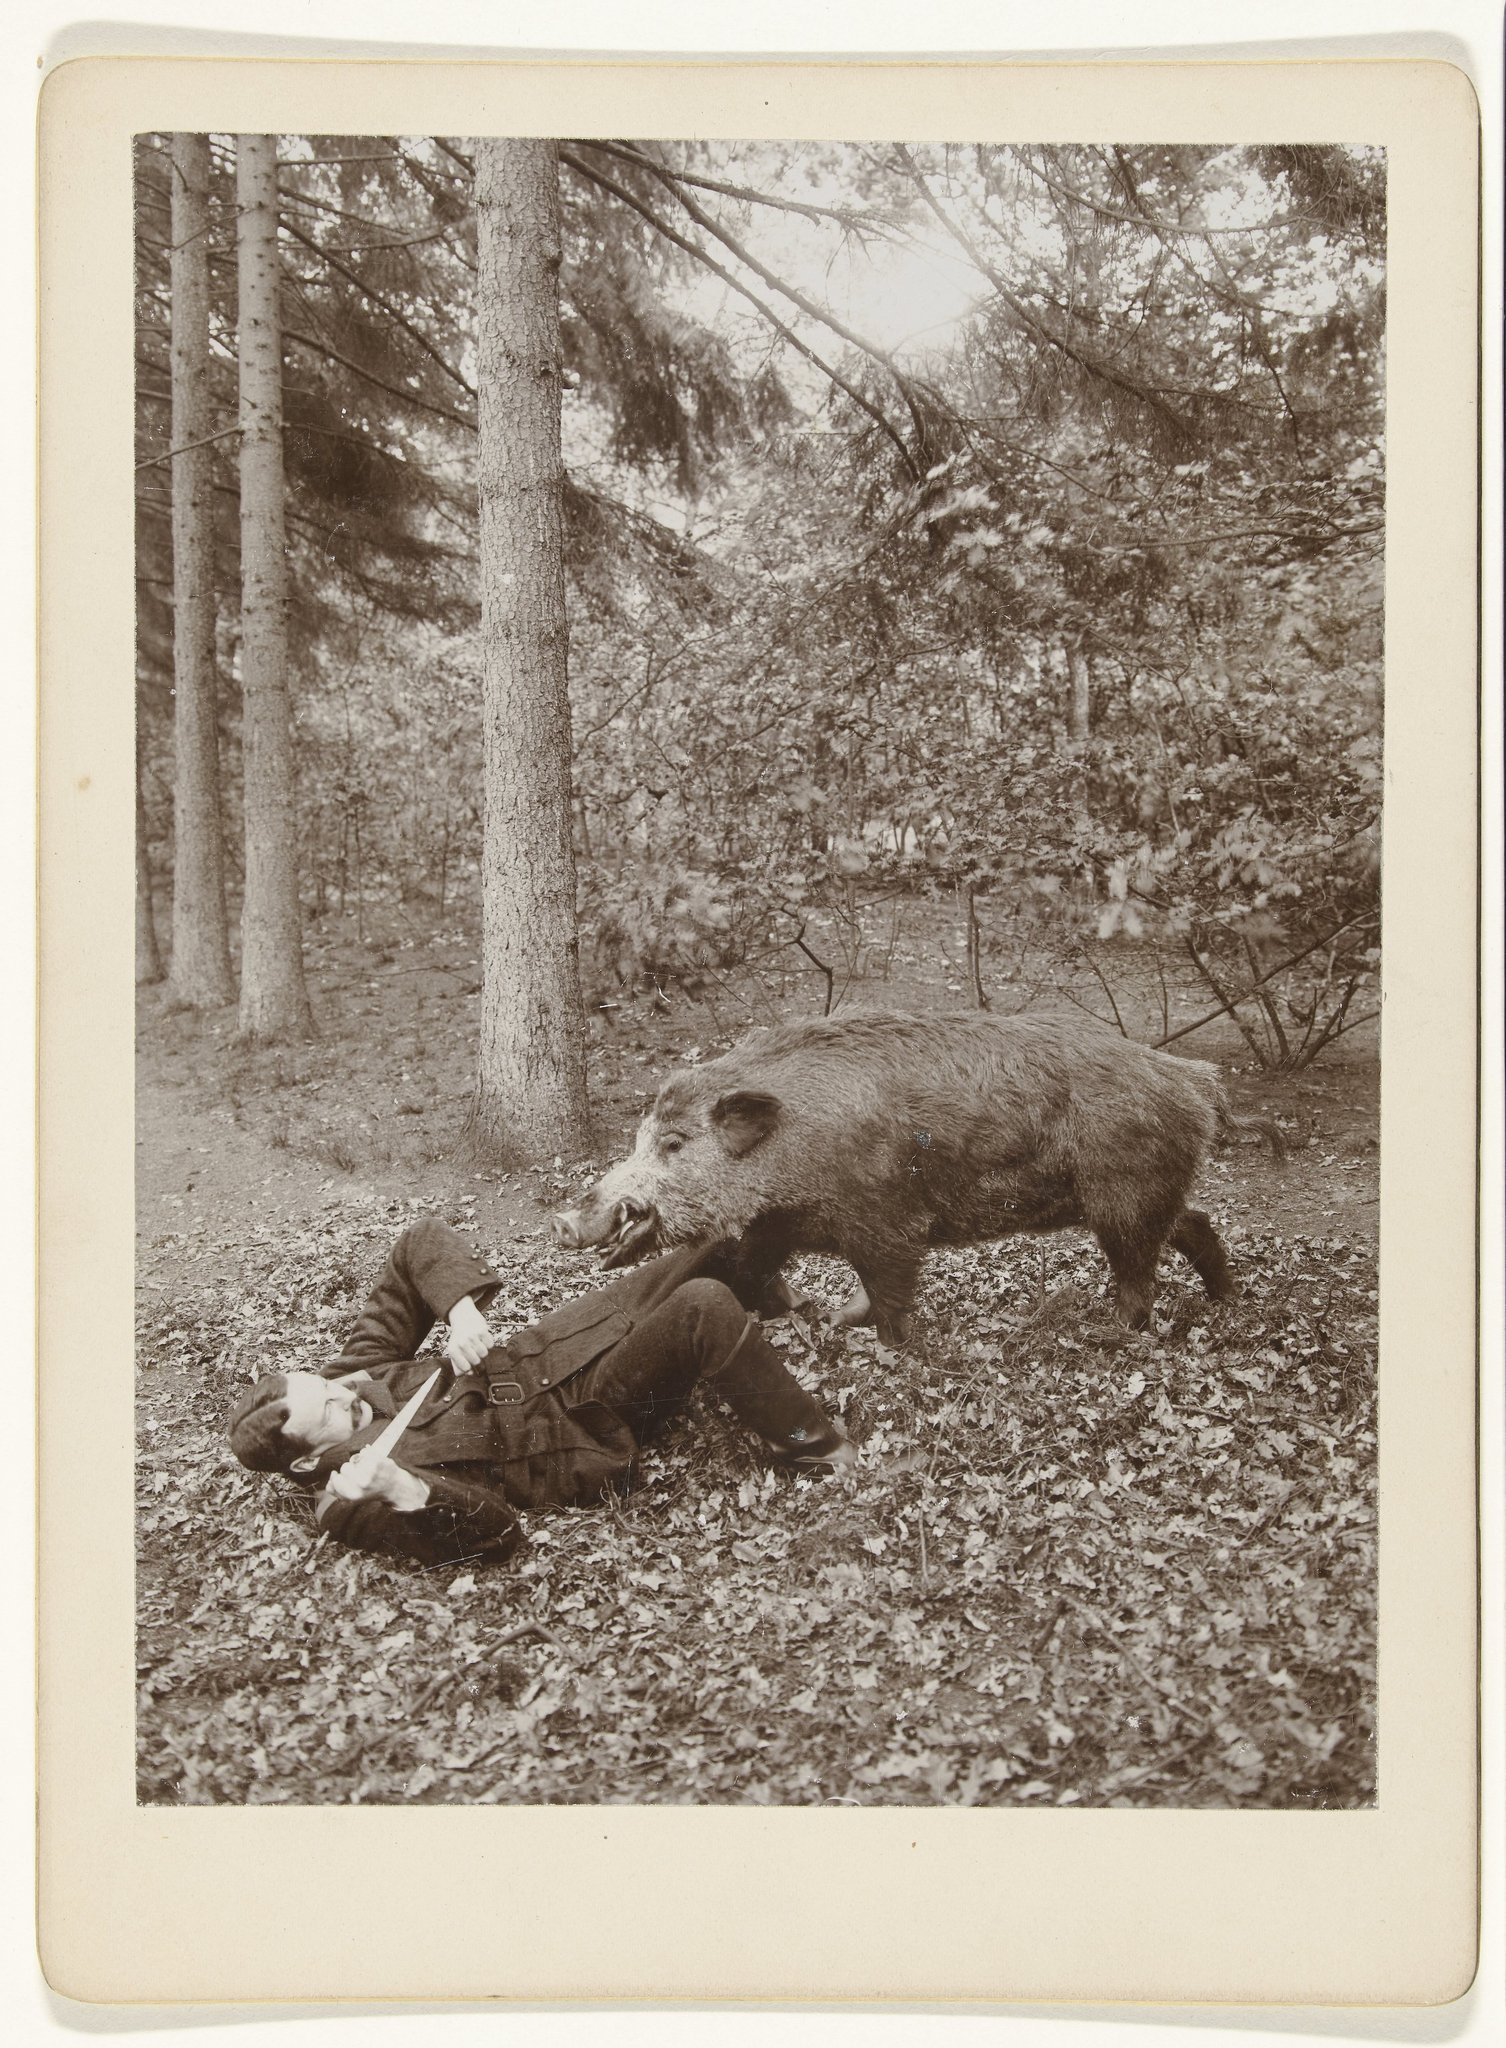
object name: photograph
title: Maarten Pauw van Wieldrecht zich met dolk verwerend tegen aanvallend (opgezet) wild zwijn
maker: henry pauw van wieldrecht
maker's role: fotograaf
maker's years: 1863-1912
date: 1805-1898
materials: cardboard, photographic support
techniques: gelatin silver print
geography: netherlands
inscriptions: annotation: ‘Oom Maarten’, annotation: ‘No 1498.’, signature and date: ‘H. Pauw v. Wieldrecht. / Mei, 1898.’